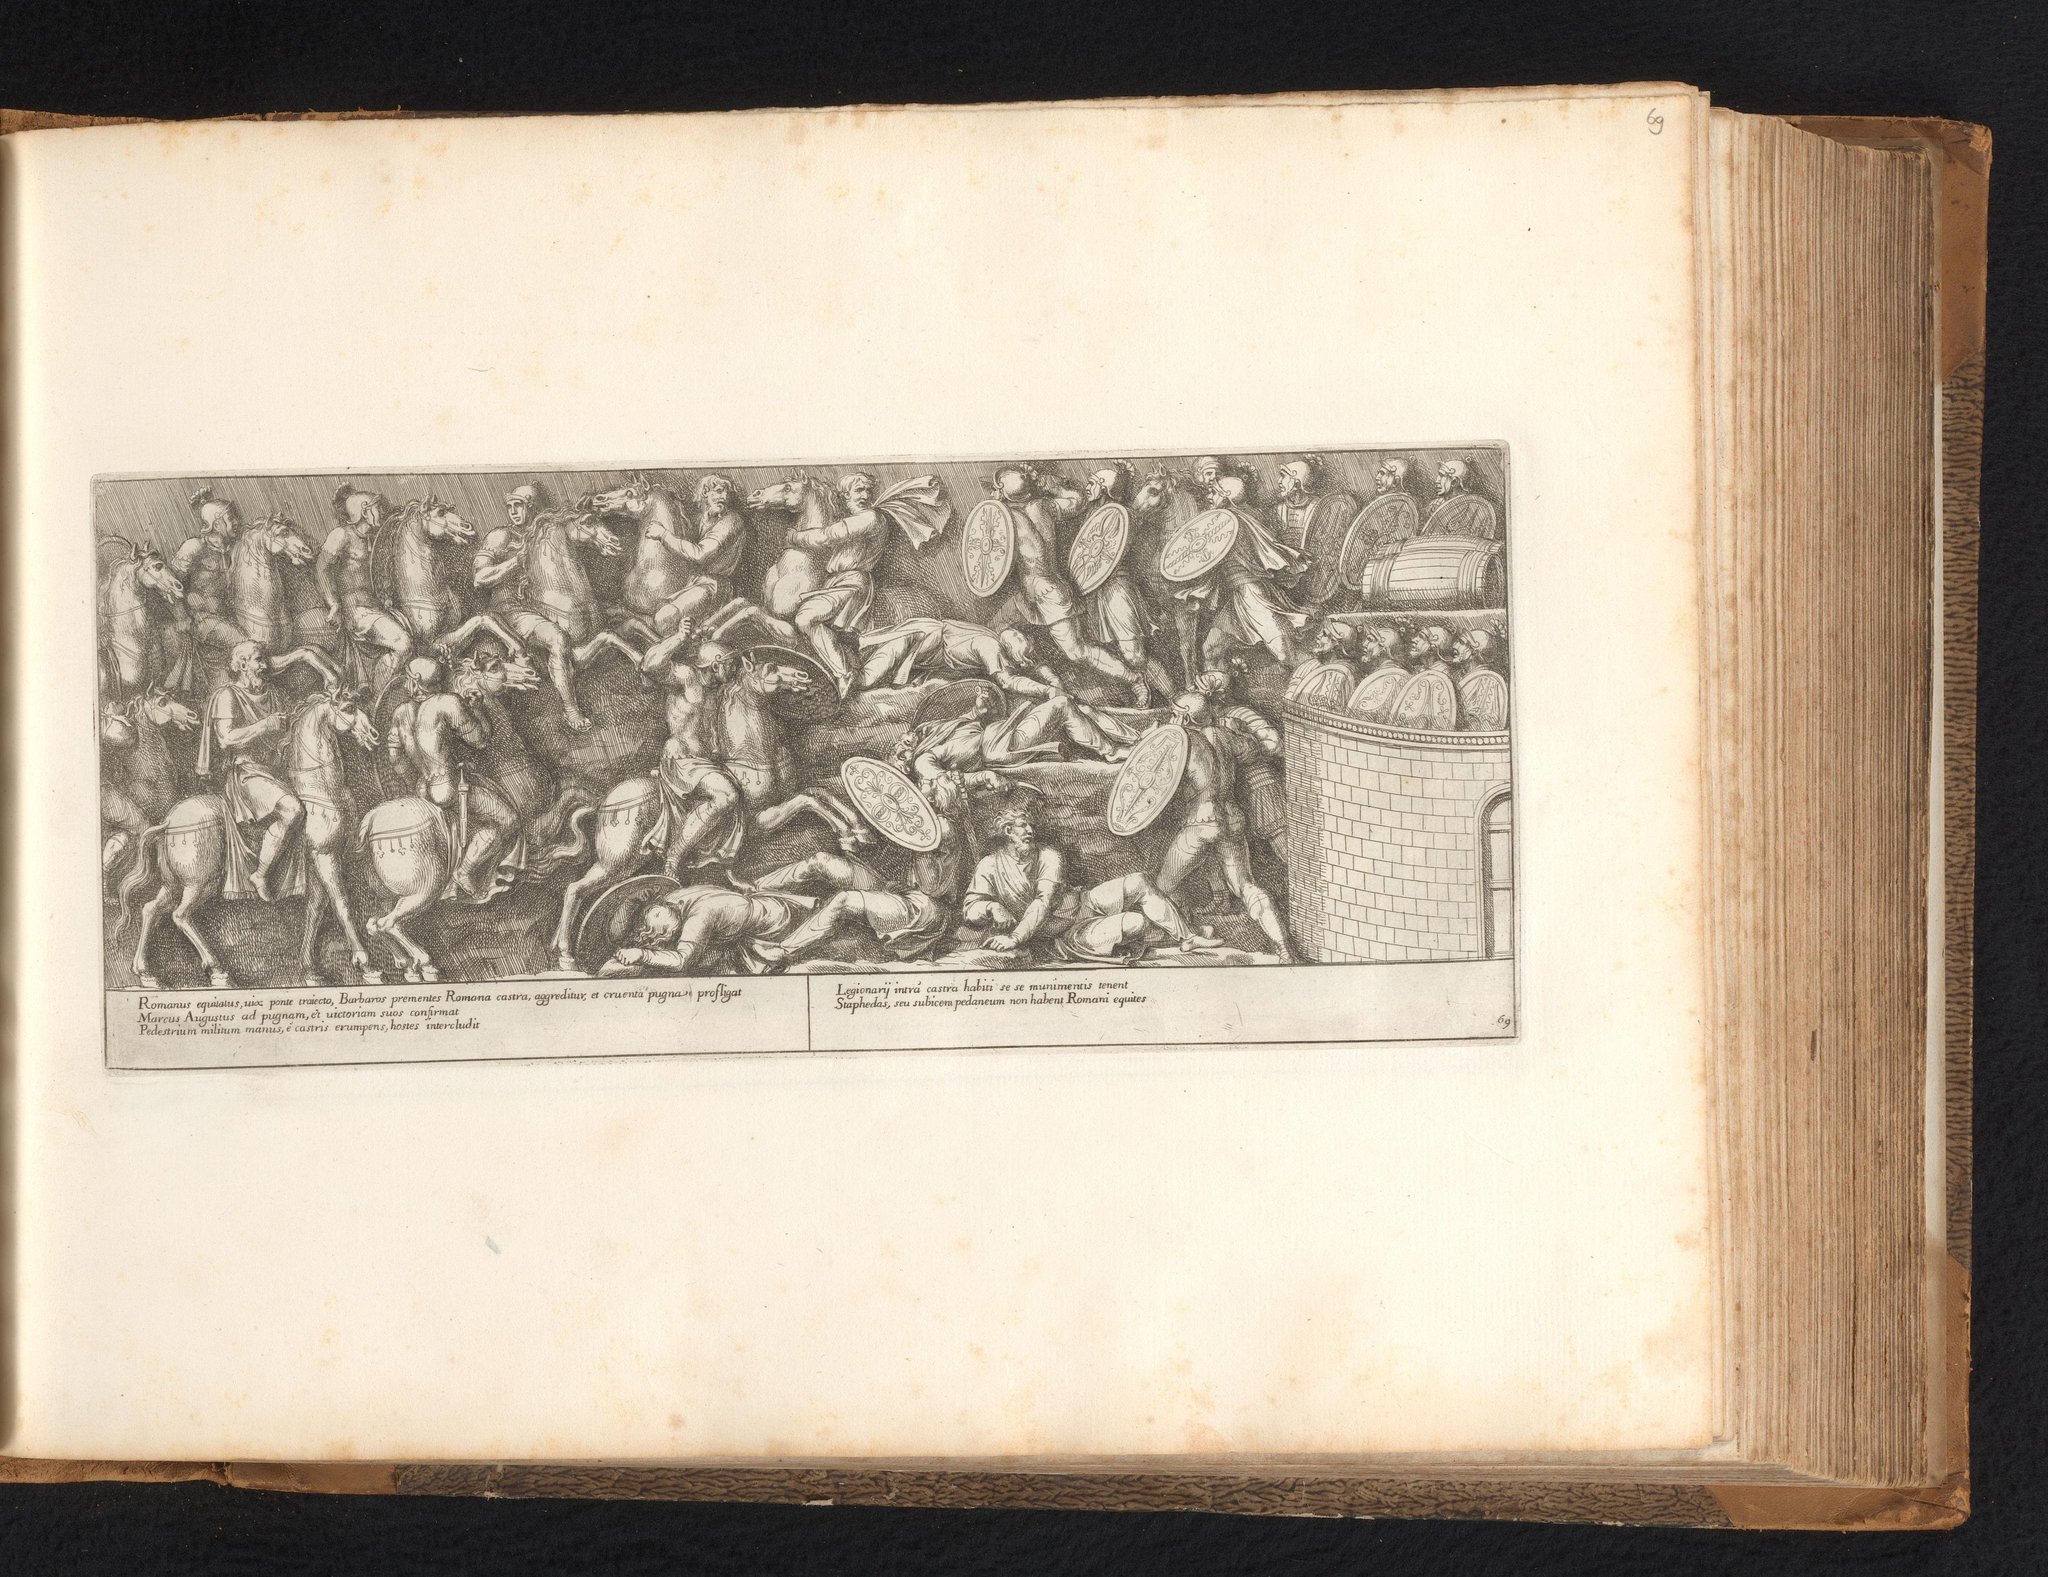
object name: print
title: Detail van het fries op de Zuil van Marcus Aurelius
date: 1672-1675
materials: paper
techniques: etching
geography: rome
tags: triumphal column with helical friezes, piece of sculpture, reproduction of a piece of sculpture, the soldier; the soldier's life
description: Detail van het spiraalvormige gebeeldhouwde fries op de Zuil van Marcus Aurelius te Rome. Het fries toont de oorlog tussen het Romeinse leger van keizer Marcus Aurelius en de Germaanse stammen der Marcomannen en Quaden en de oorlog tegen de Sarmaten die vanuit het huidige Iran Hongarije waren binnengevallen. Tekst in de ondermarge. Prent maakt deel uit van een album.